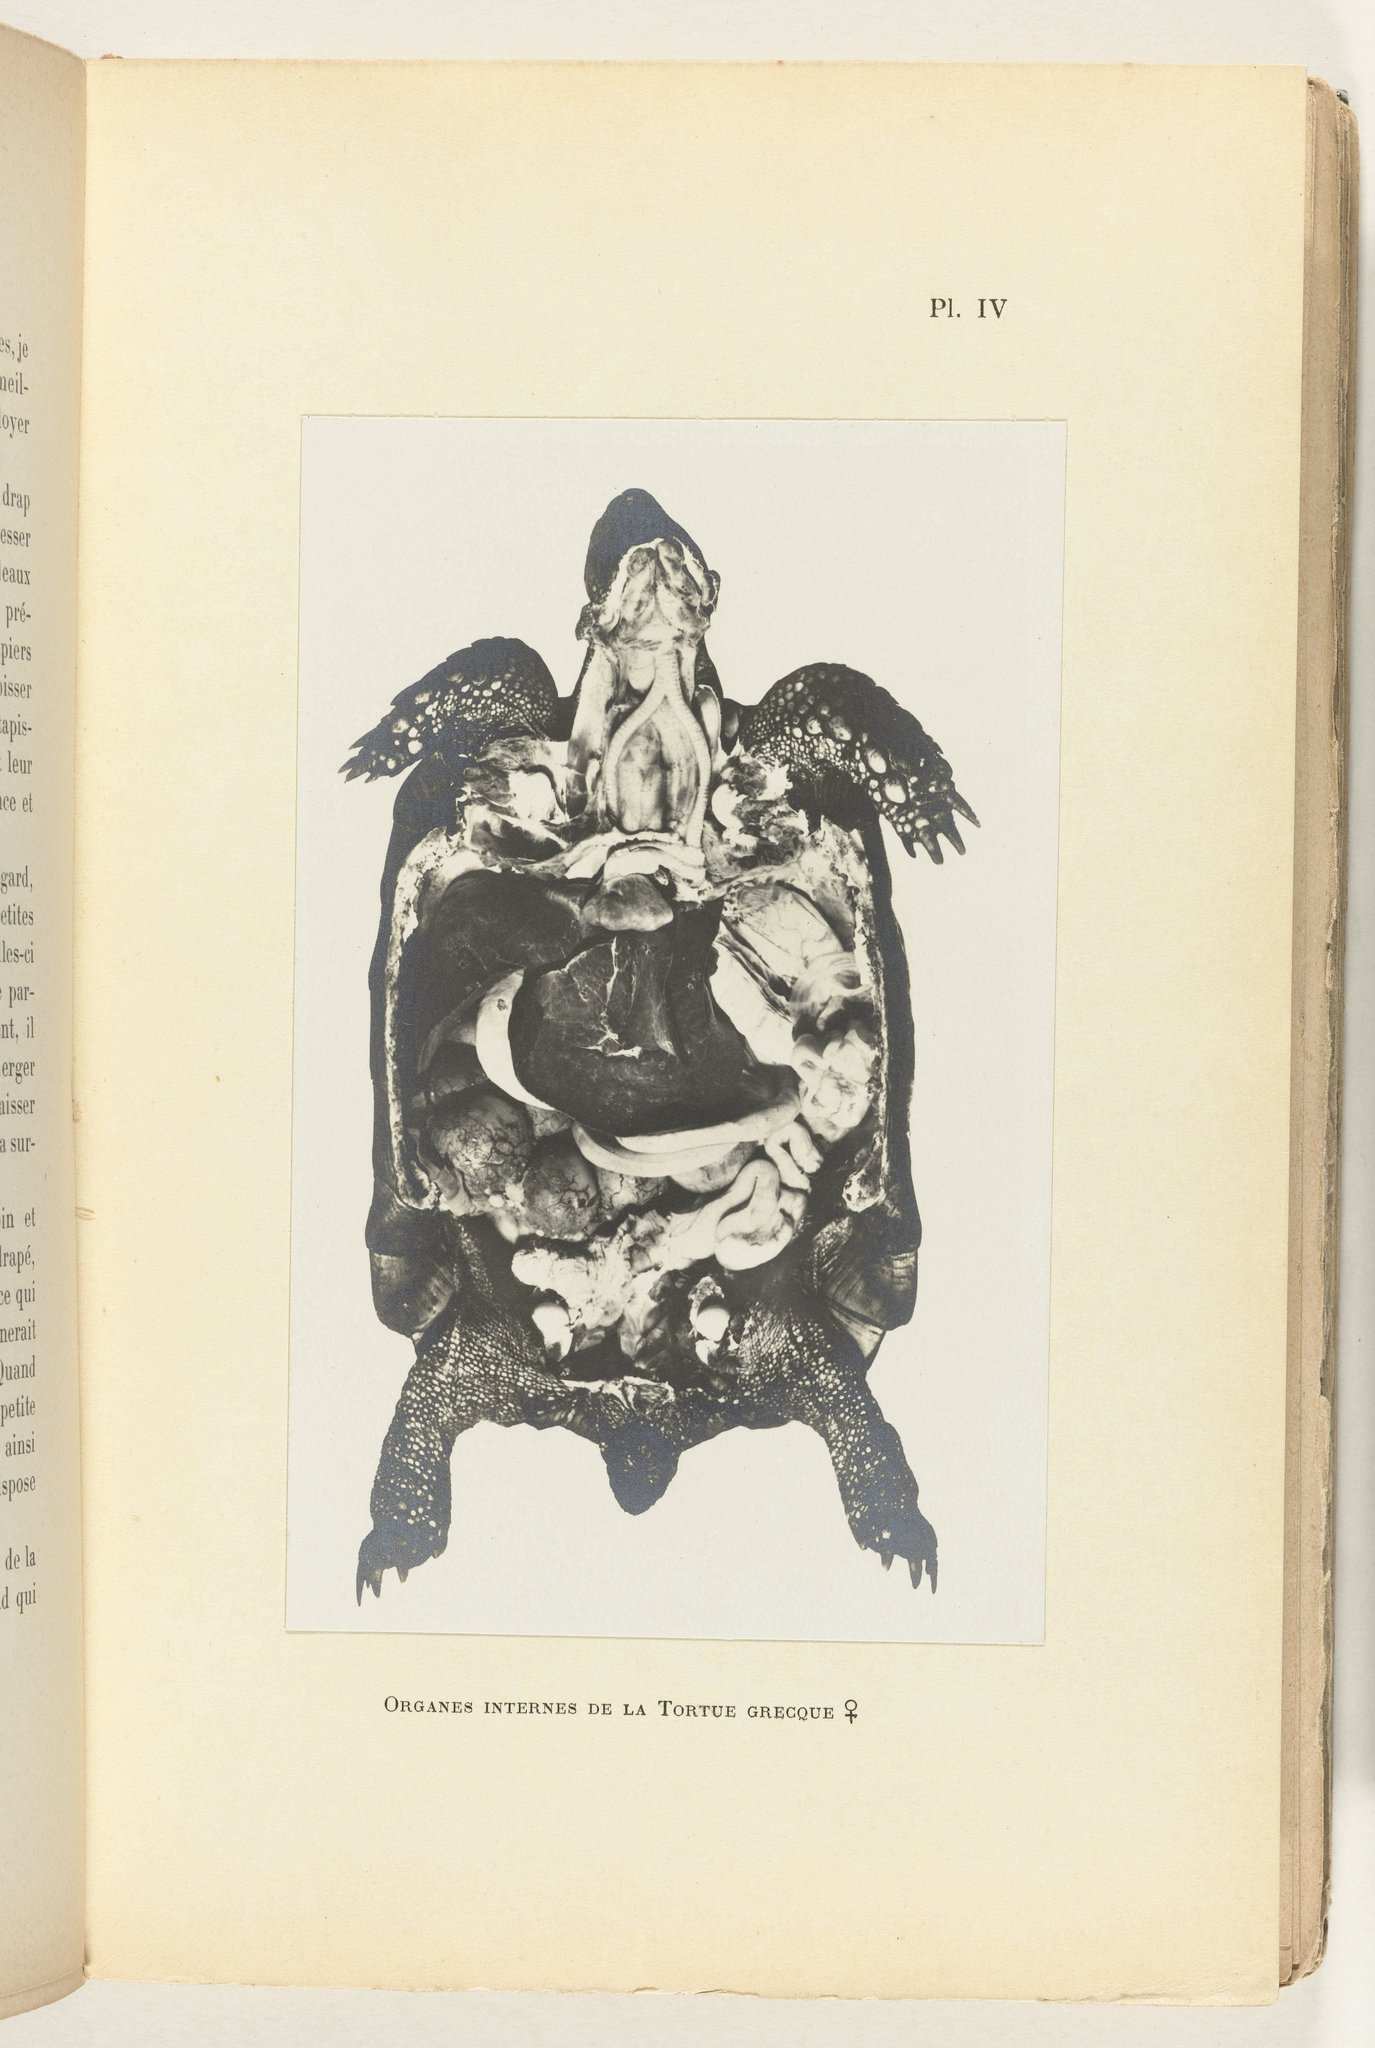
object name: photograph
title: Organes internes de la Tortue Grecque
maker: adolphe louis donnadieu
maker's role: wetenschapper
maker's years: 1840-1911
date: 1891-1901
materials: photographic support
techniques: gelatin silver print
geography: paris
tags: tortoises, turtles, physiology and anatomy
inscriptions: number: ‘Pl. IV’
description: Foto in album 'La photographie des objets immergés', 1901.